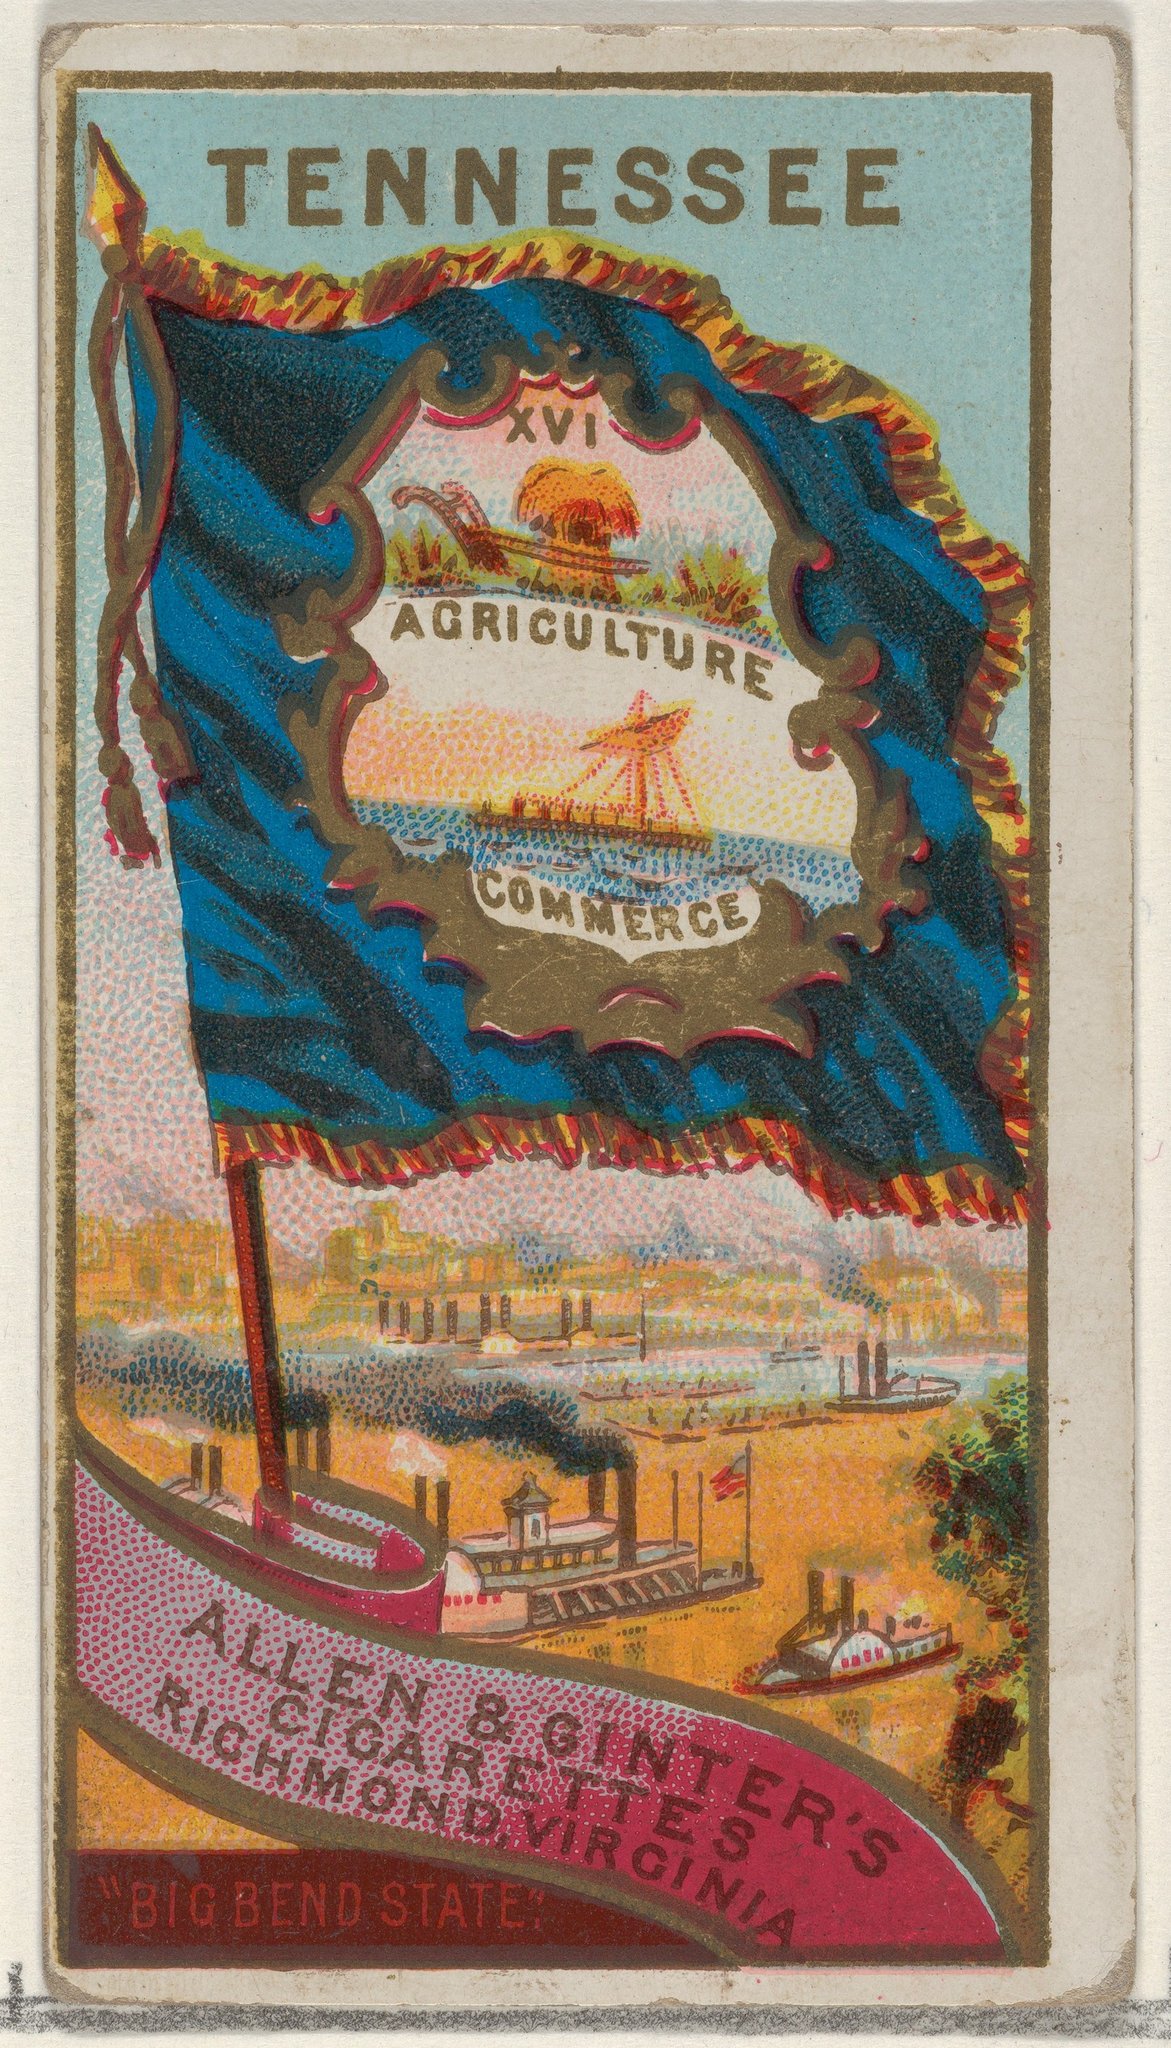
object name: print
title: Tennessee, from Flags of the States and Territories (N11) for Allen & Ginter Cigarettes Brands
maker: allen & ginter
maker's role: publisher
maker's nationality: american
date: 1888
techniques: color lithograph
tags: flags